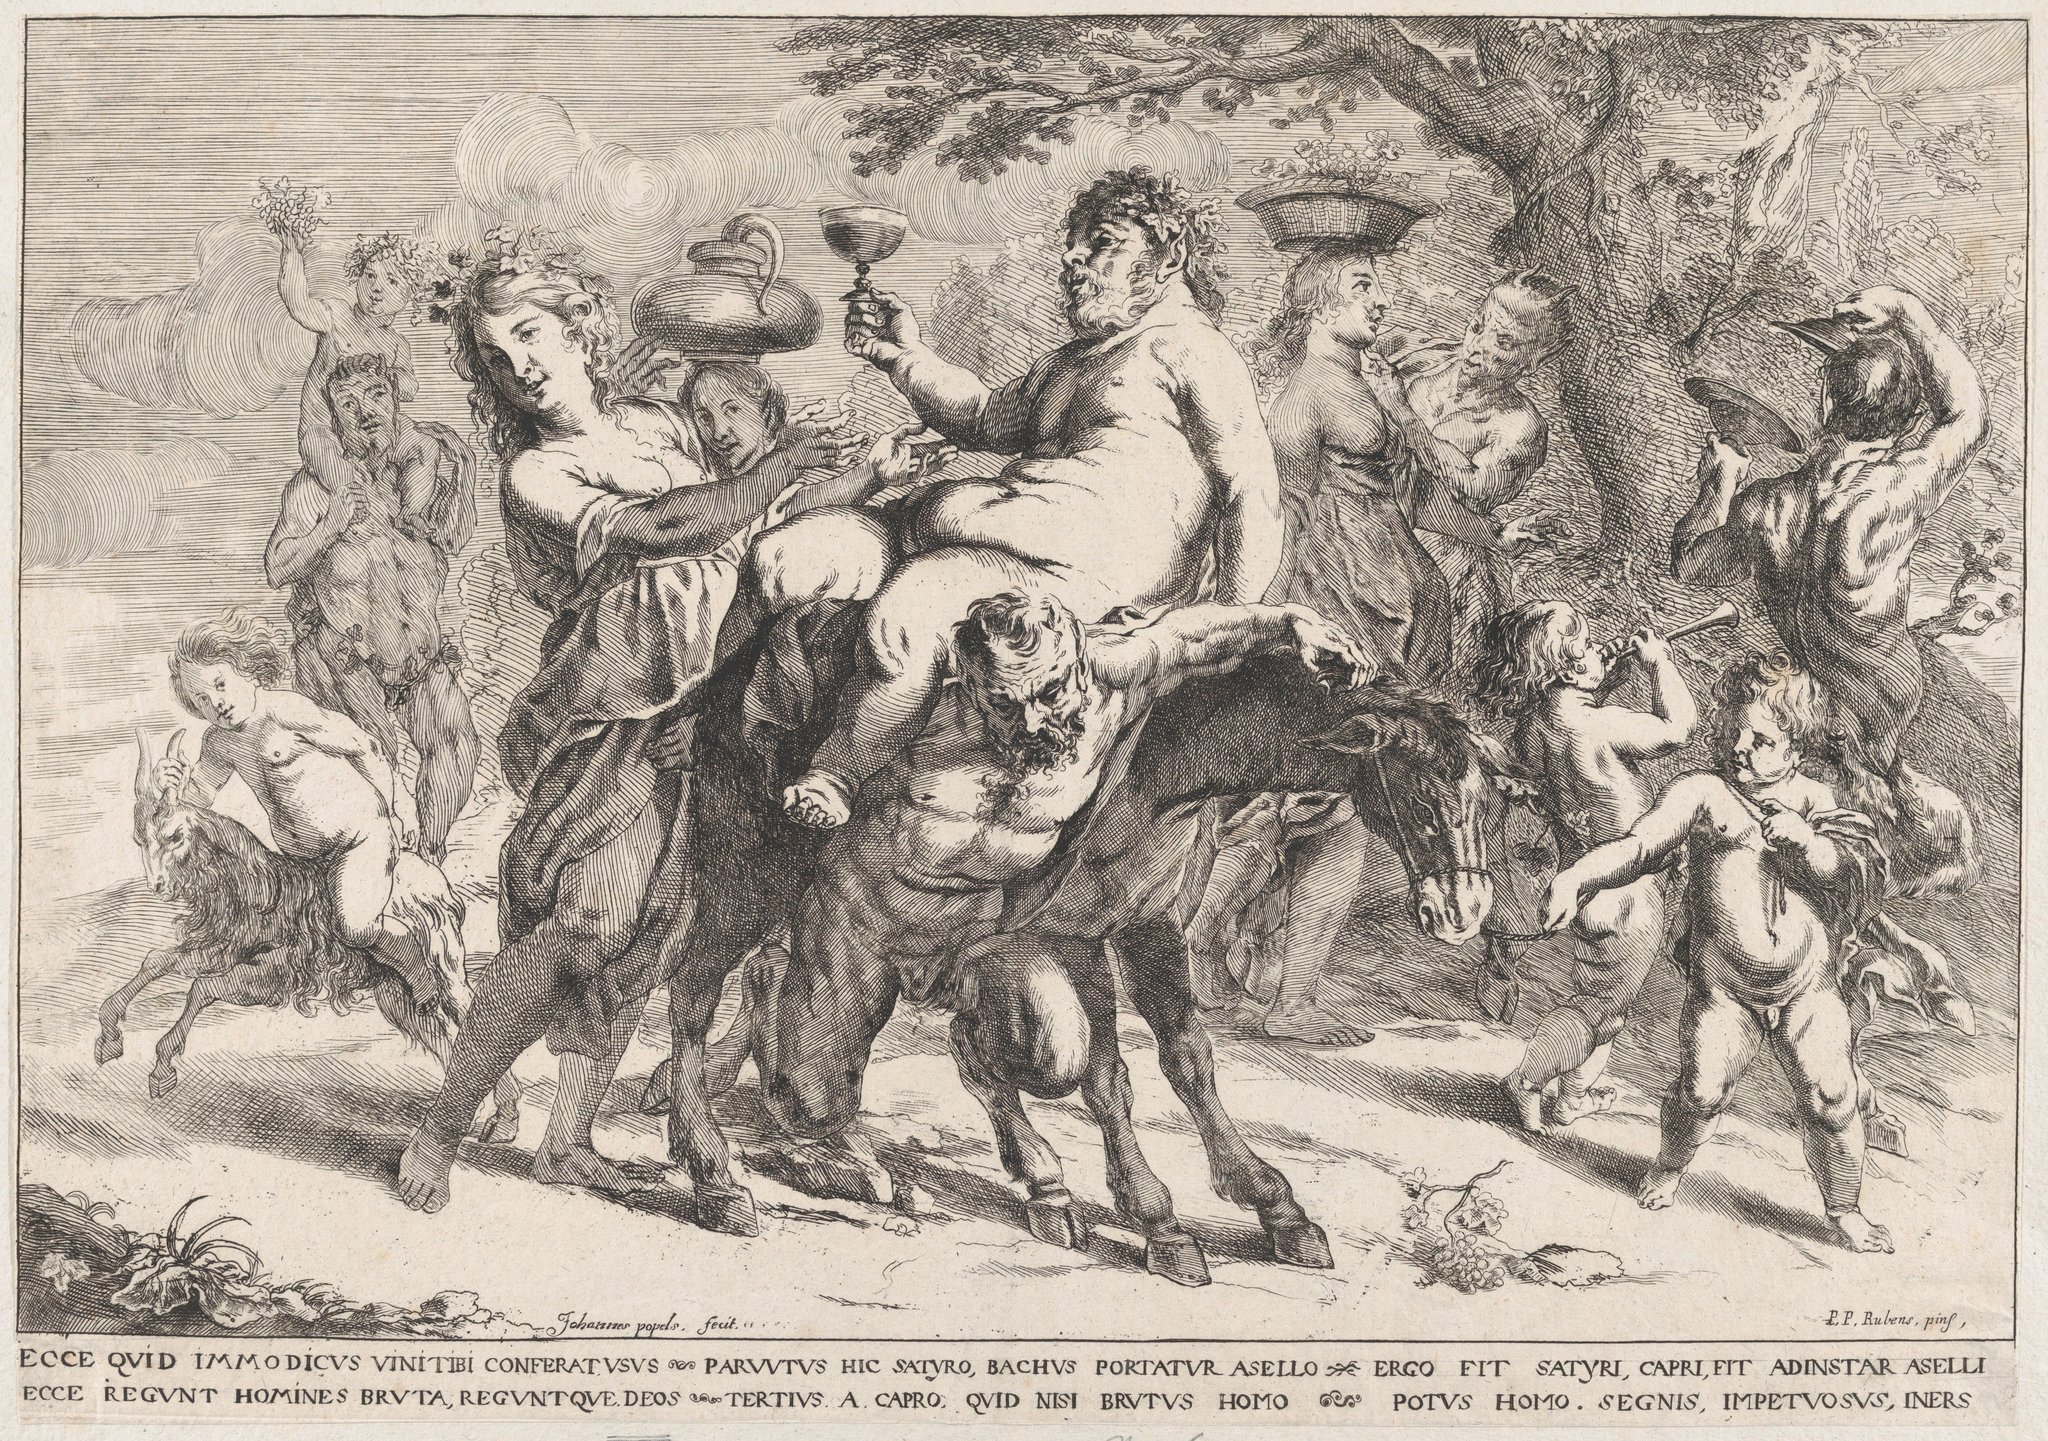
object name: print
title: The Triumph of Bacchus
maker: jan popels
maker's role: artist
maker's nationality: flemish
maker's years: 1633-1663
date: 1633-1663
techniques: etching